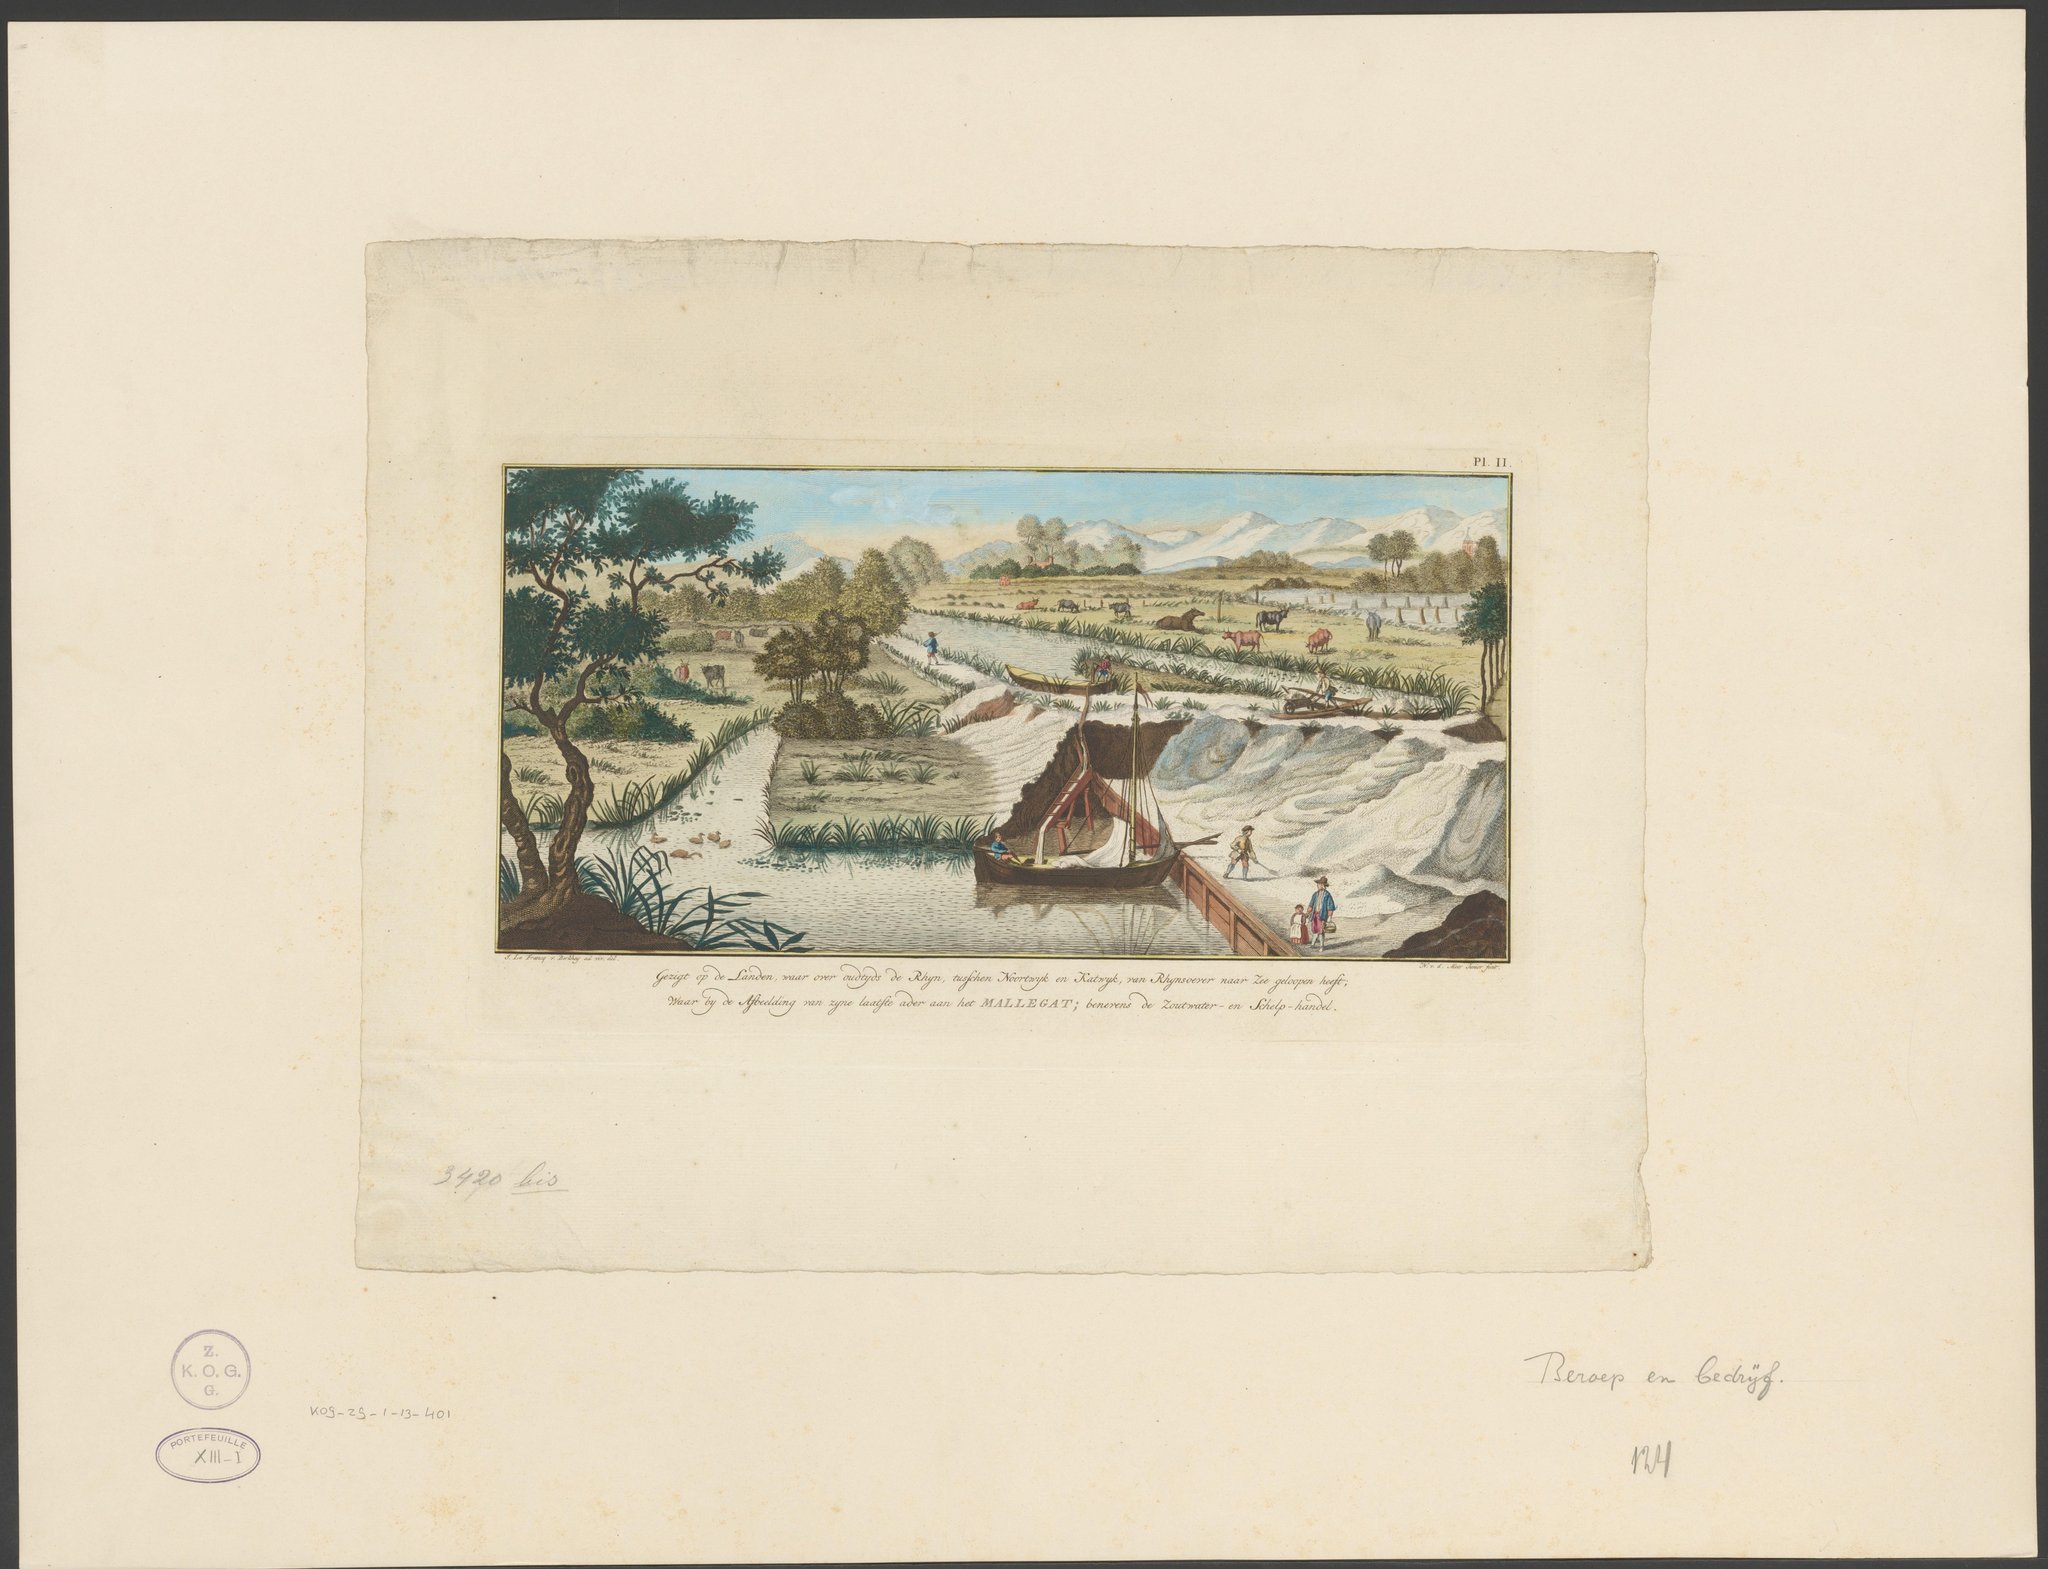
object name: print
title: Oude Rijn bij het Mallegat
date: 1769-1779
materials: paper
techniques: engraving, etching, hand coloring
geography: amsterdam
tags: shell fishery, merchant shipping, shipping trade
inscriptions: collector's mark: Lugt 1641, stamp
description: De landerijen rond het Mallegat en de Oude Rijn tussen Katwijk en Noordwijk. Op de voorgrond wordt een lading van een hoger gelegen in een lagergelegen schip gebracht. Langs de kade liggen bergen schelpen. Op de achtergrond de duinen. Rechtsboven genummerd: Pl. II. Onderwerpsrubrieken binnen de Atlas Zeden en Gewoonten: Handel, Nijverheid en verkeer, Beroep en bedrijf, Mannelijk, Turfmaken, darinkdelven, zoutziederij, schelpenhandel, lijmmakerij.